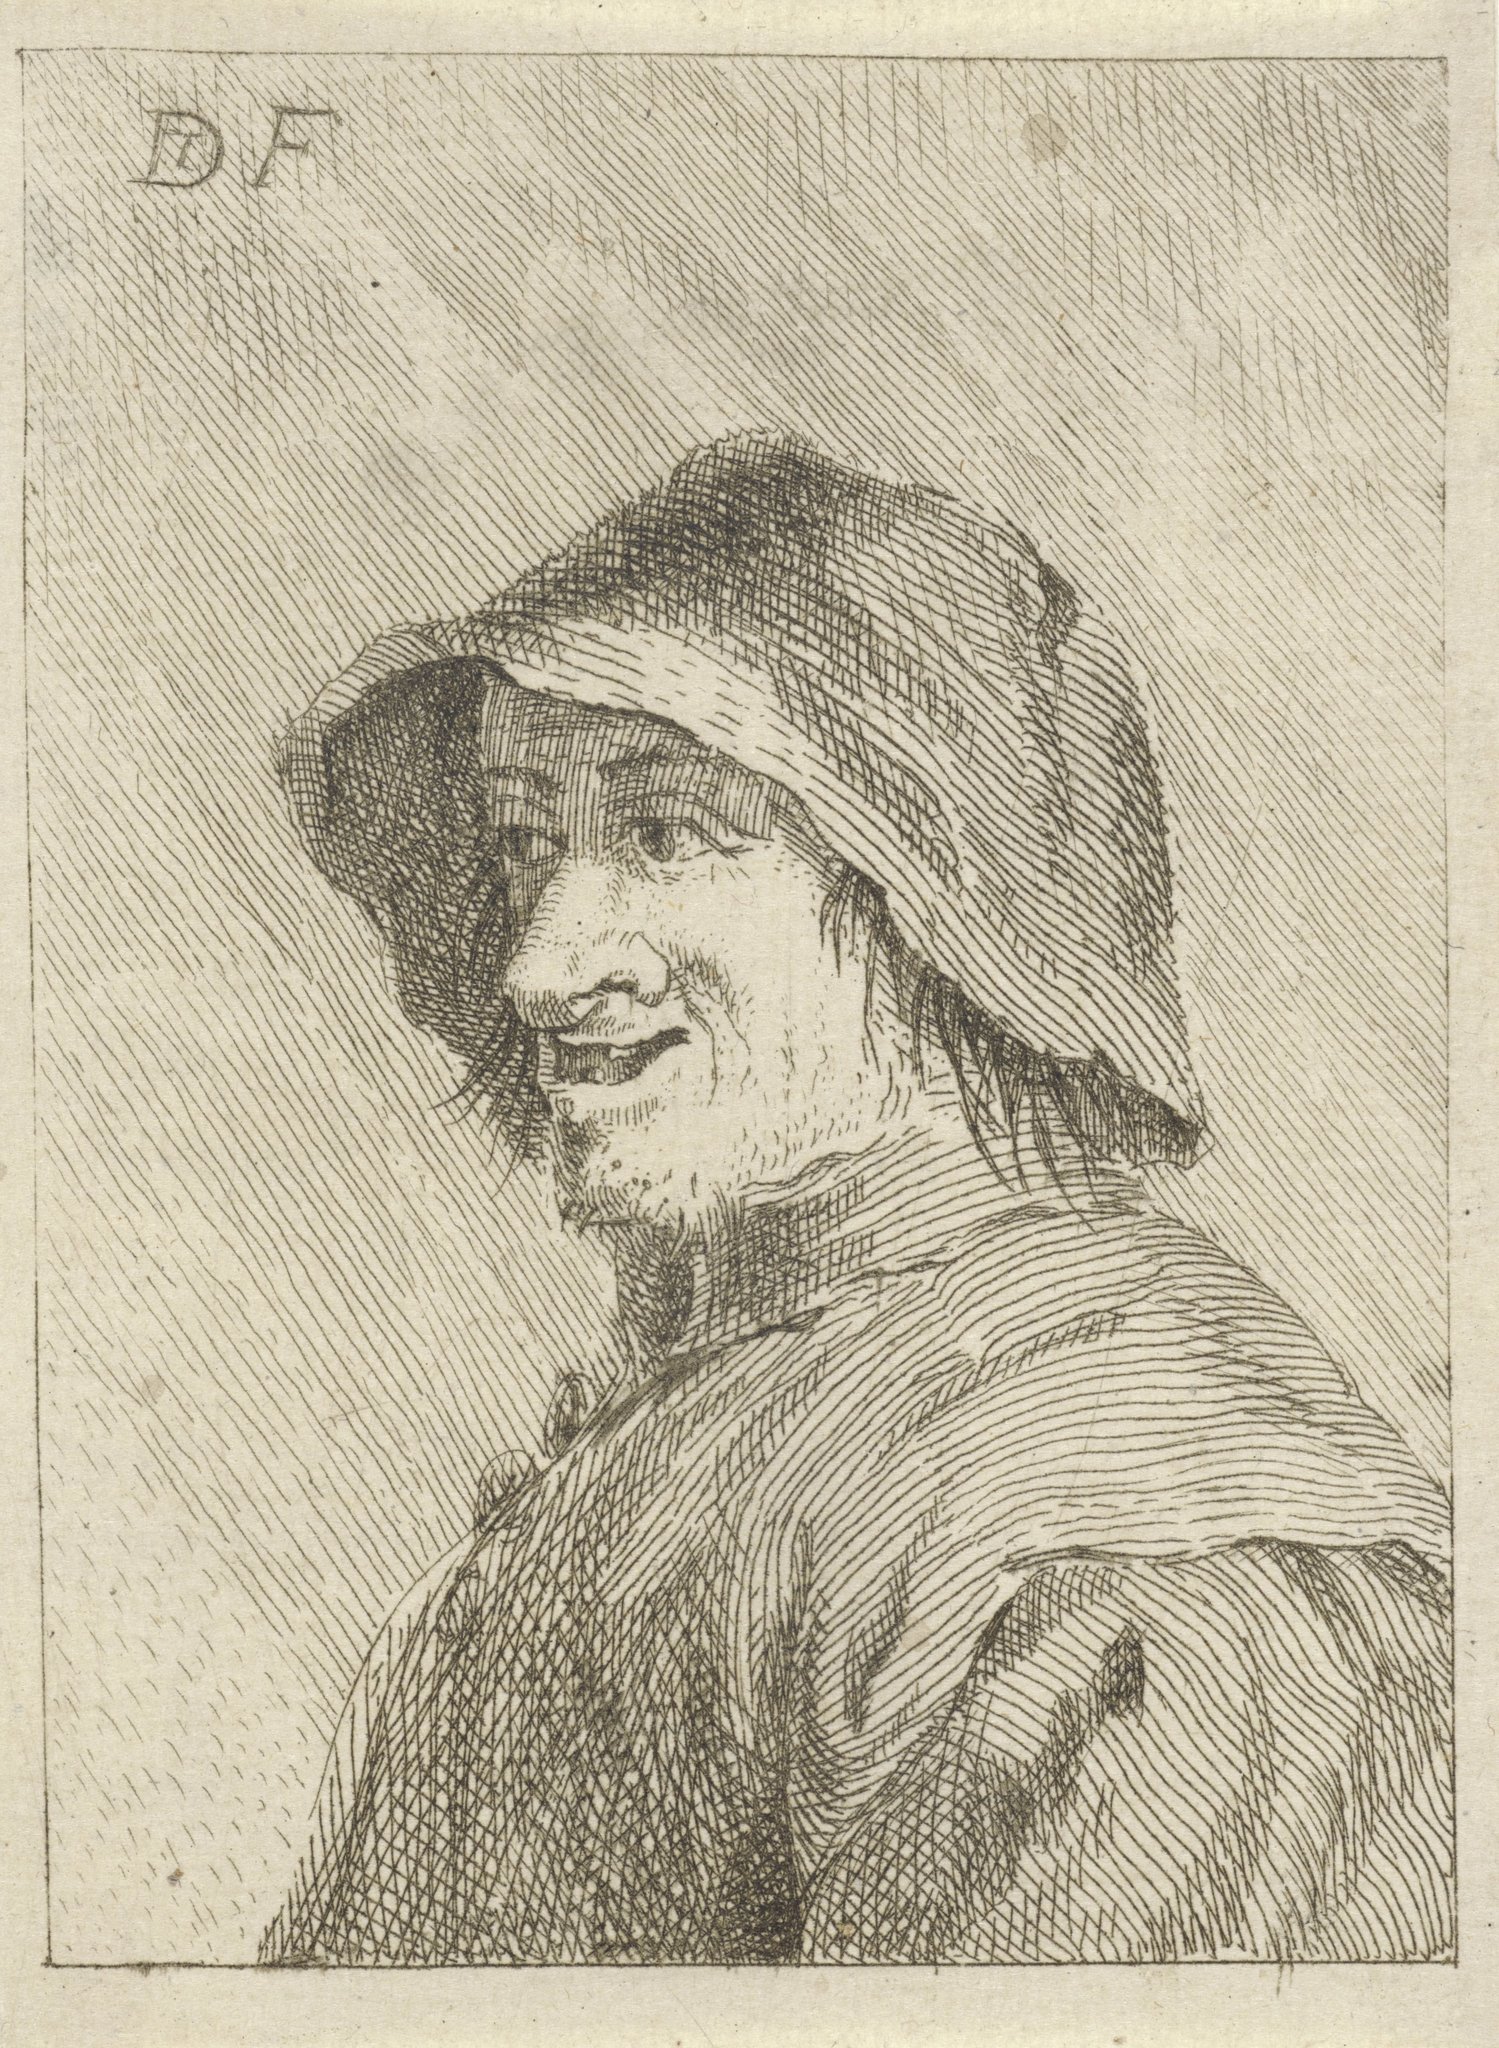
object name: print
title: Boer met hoed op het hoofd naar links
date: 1626-1740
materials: paper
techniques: etching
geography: low countries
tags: farmers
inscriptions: collector's mark: Lugt 2228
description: Boer met een hoed op het hoofd en stoppels op zijn kin.